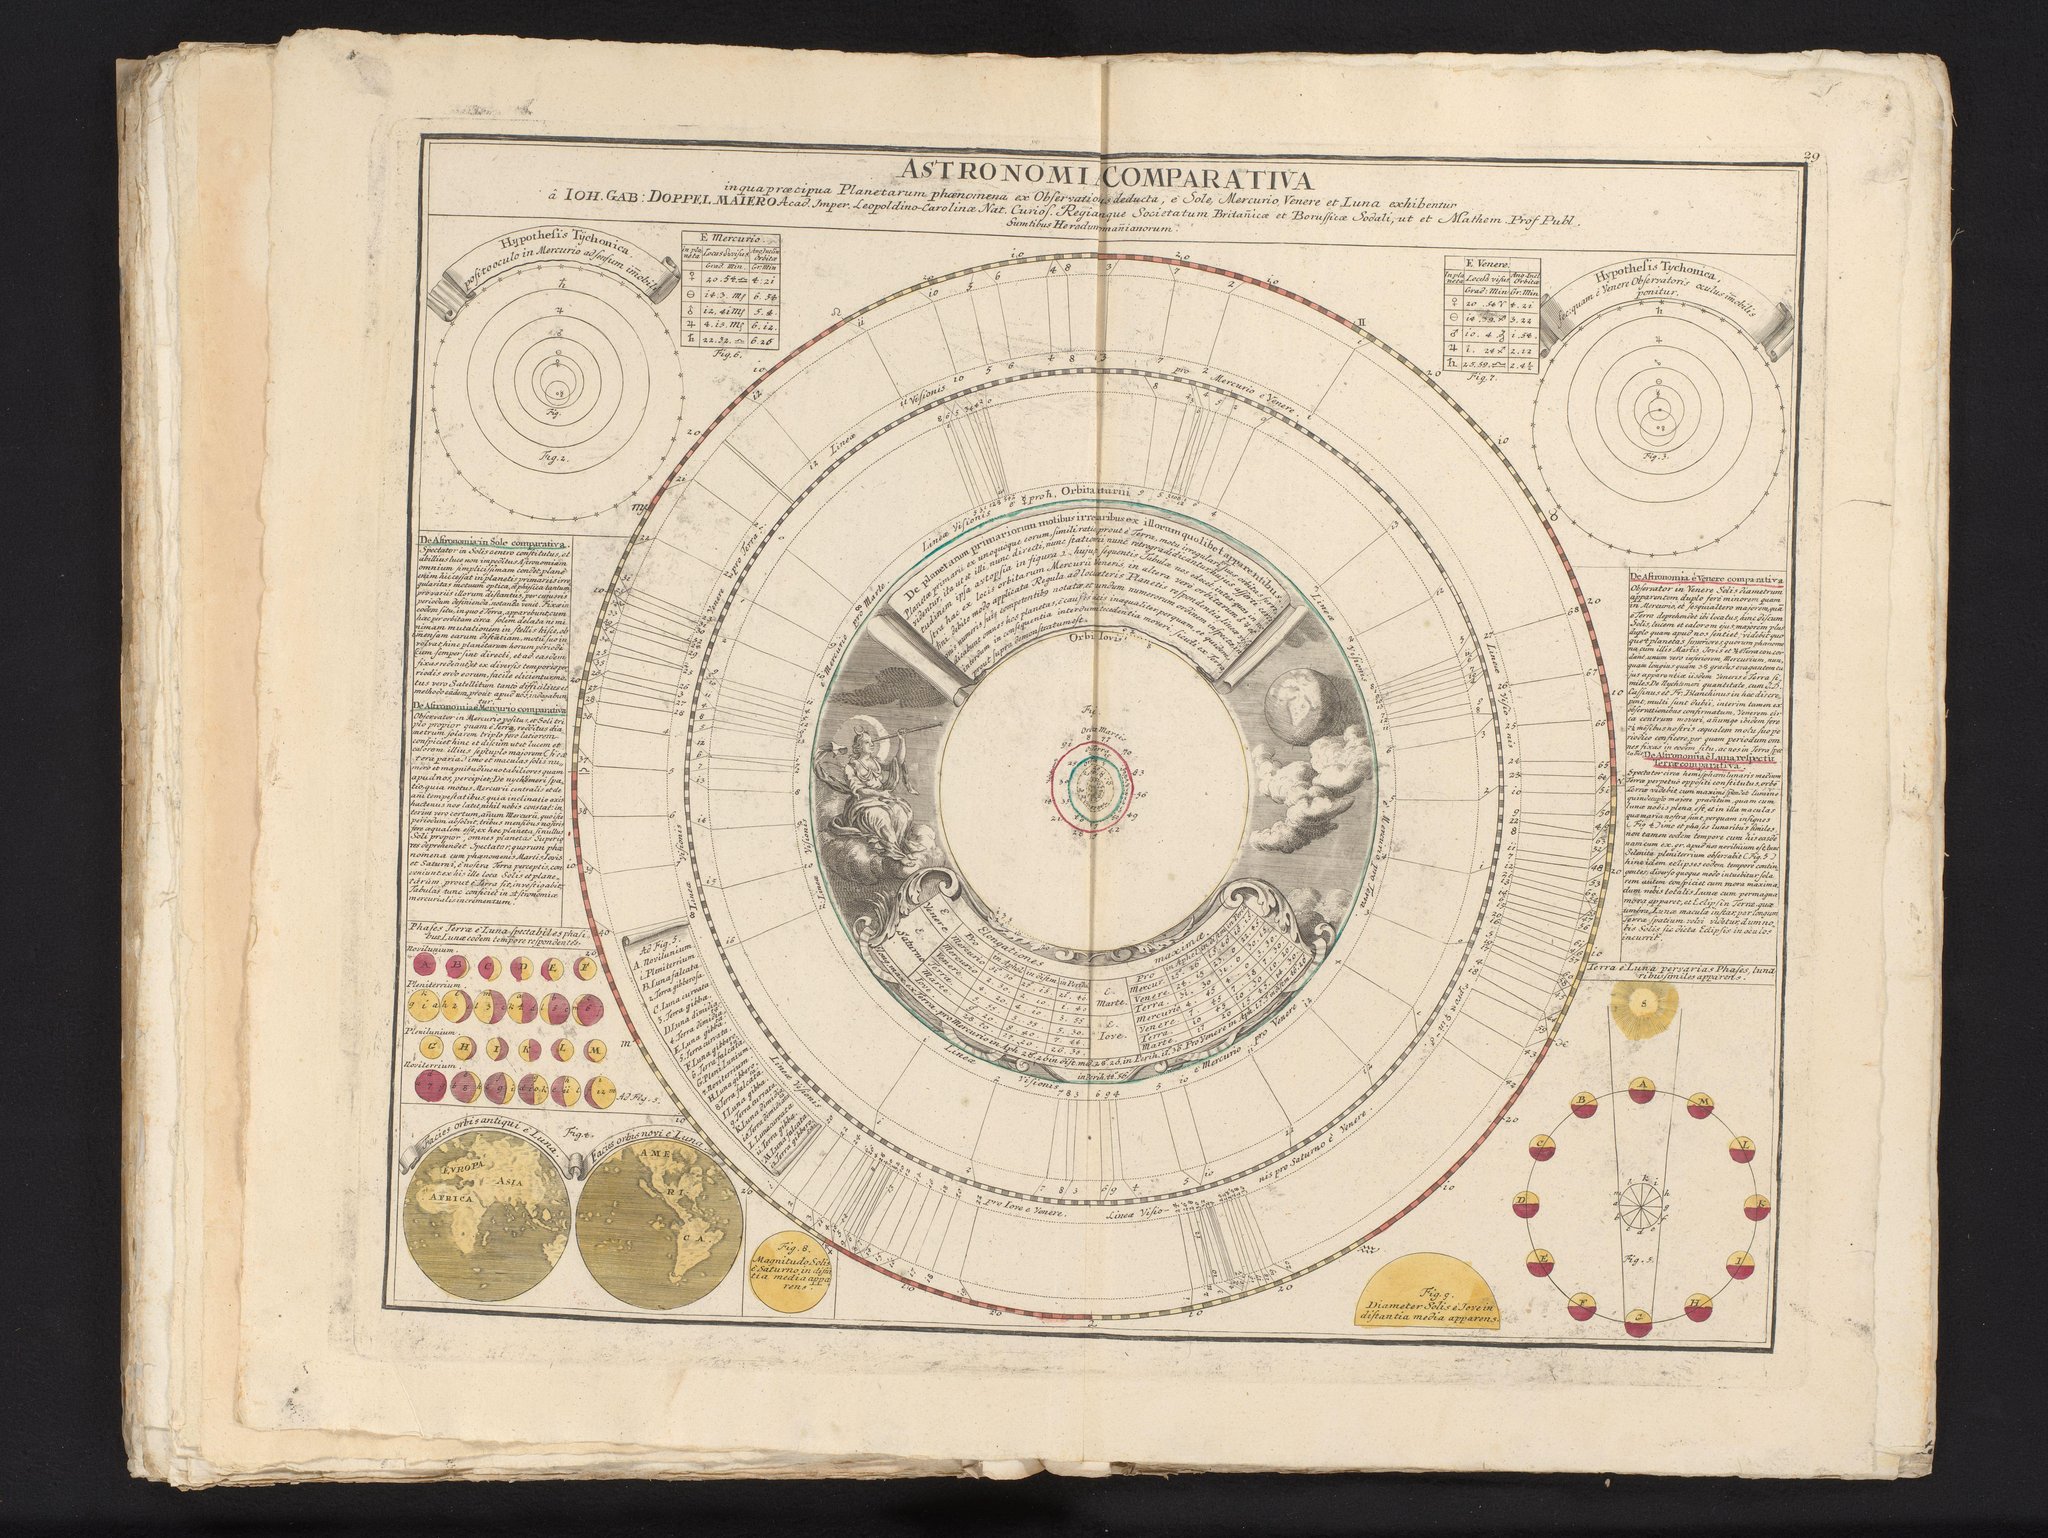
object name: print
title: Uitleg en theorieën over verschillende astronomische verschijnselen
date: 1742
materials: paper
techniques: engraving, etching, hand coloring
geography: nuremberg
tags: moon as celestial body, star-chart, star map, stars and constellations